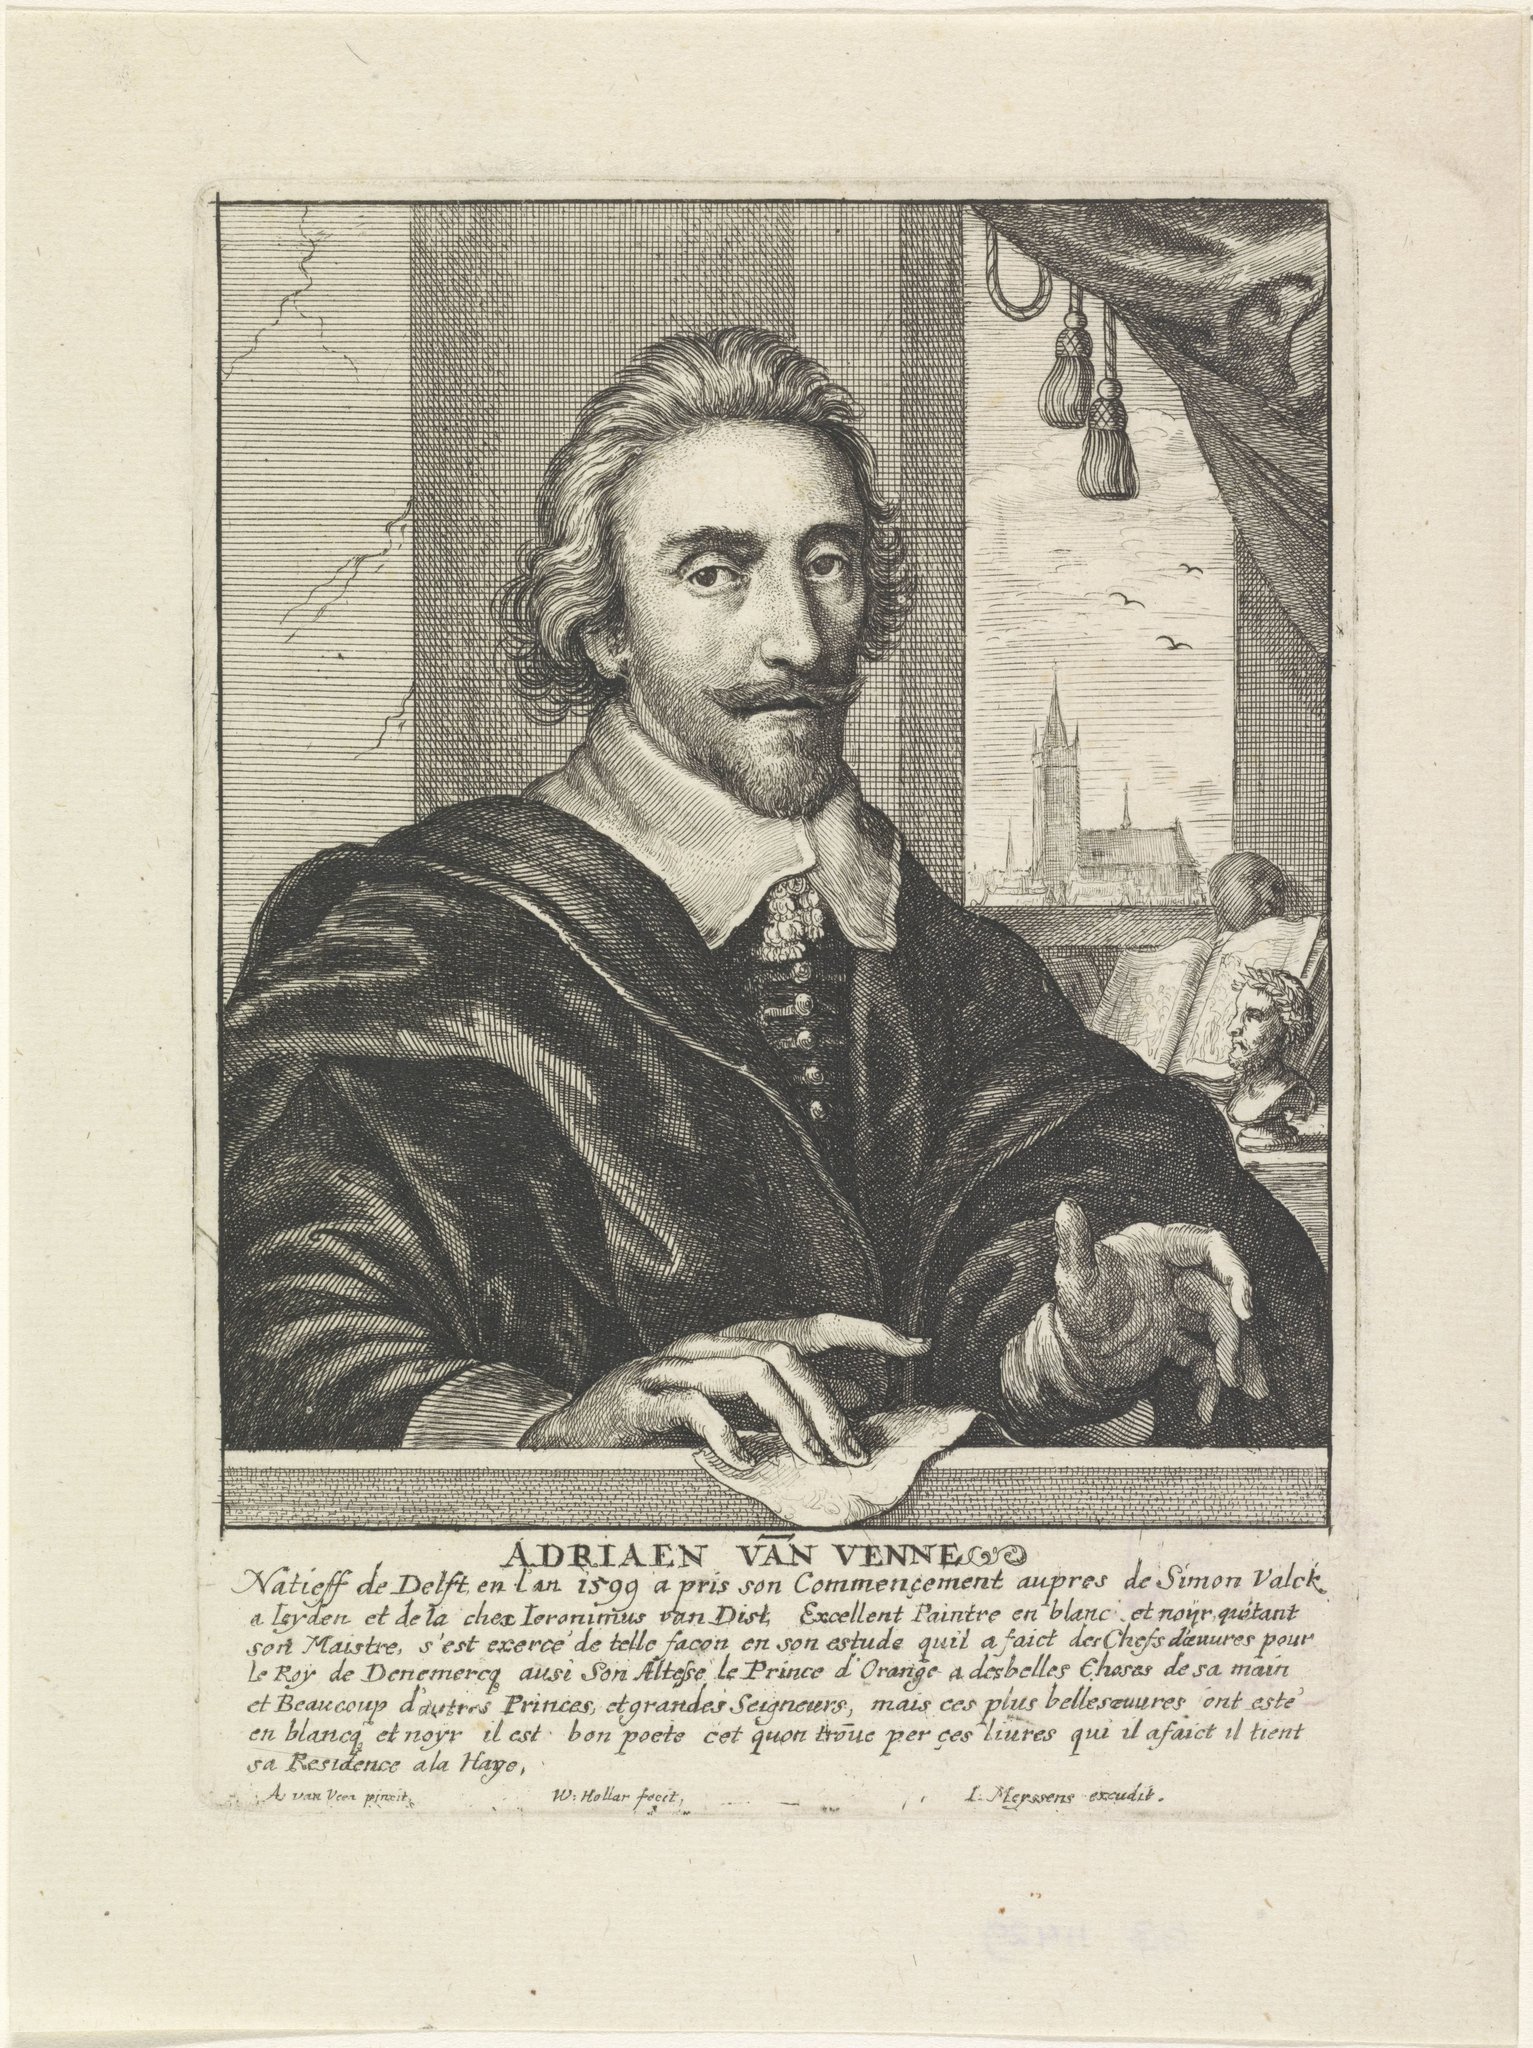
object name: print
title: Portretten van kunstenaars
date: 1649-1670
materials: paper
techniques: etching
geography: antwerp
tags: delft, the hague, painter, print maker, draughtsman, adriaen pietersz van de venne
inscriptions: collector's mark: Lugt 240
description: De prent maakt deel uit van de negendelige serie "Image de divers hommes desprit sublime".